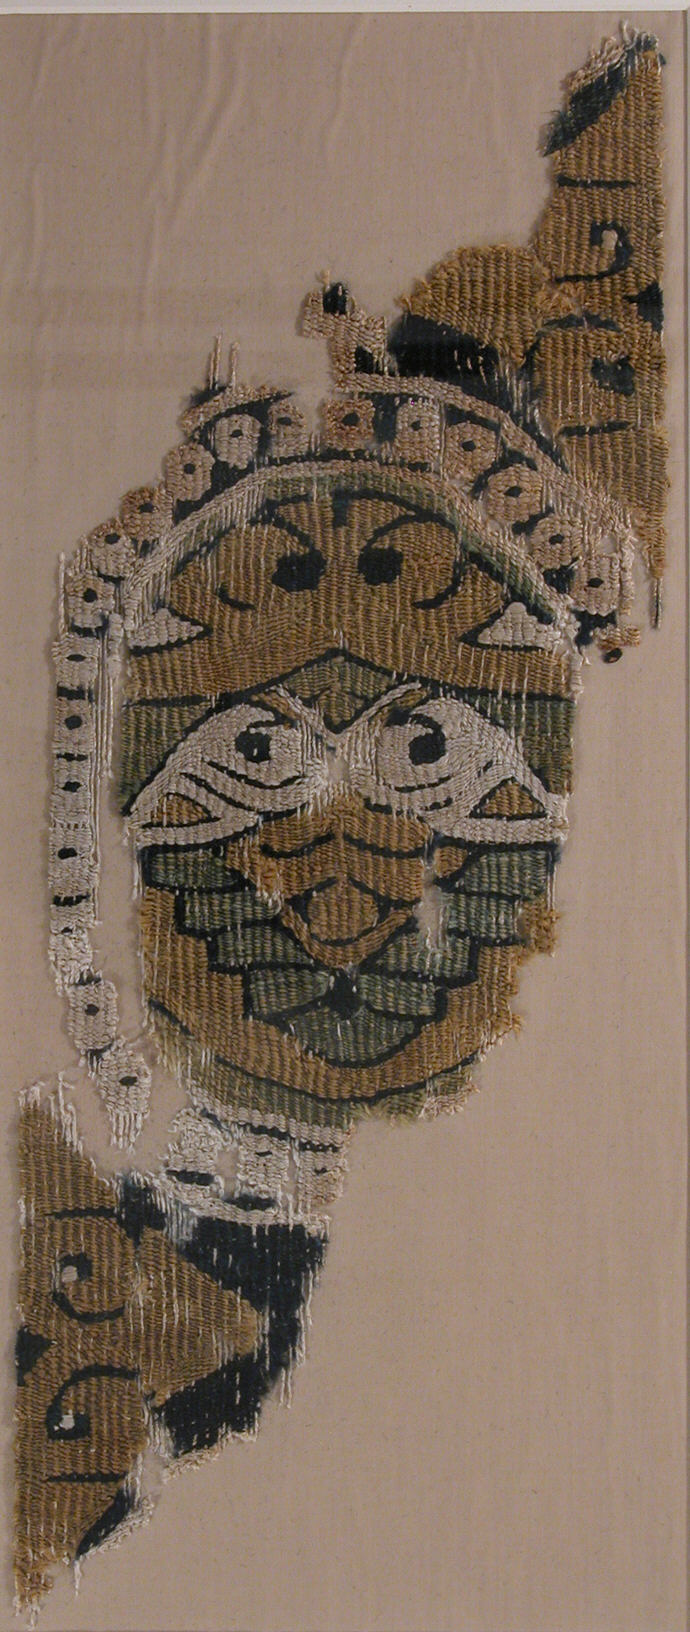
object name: textile fragment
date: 801-900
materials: linen, wool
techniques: weave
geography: egypt